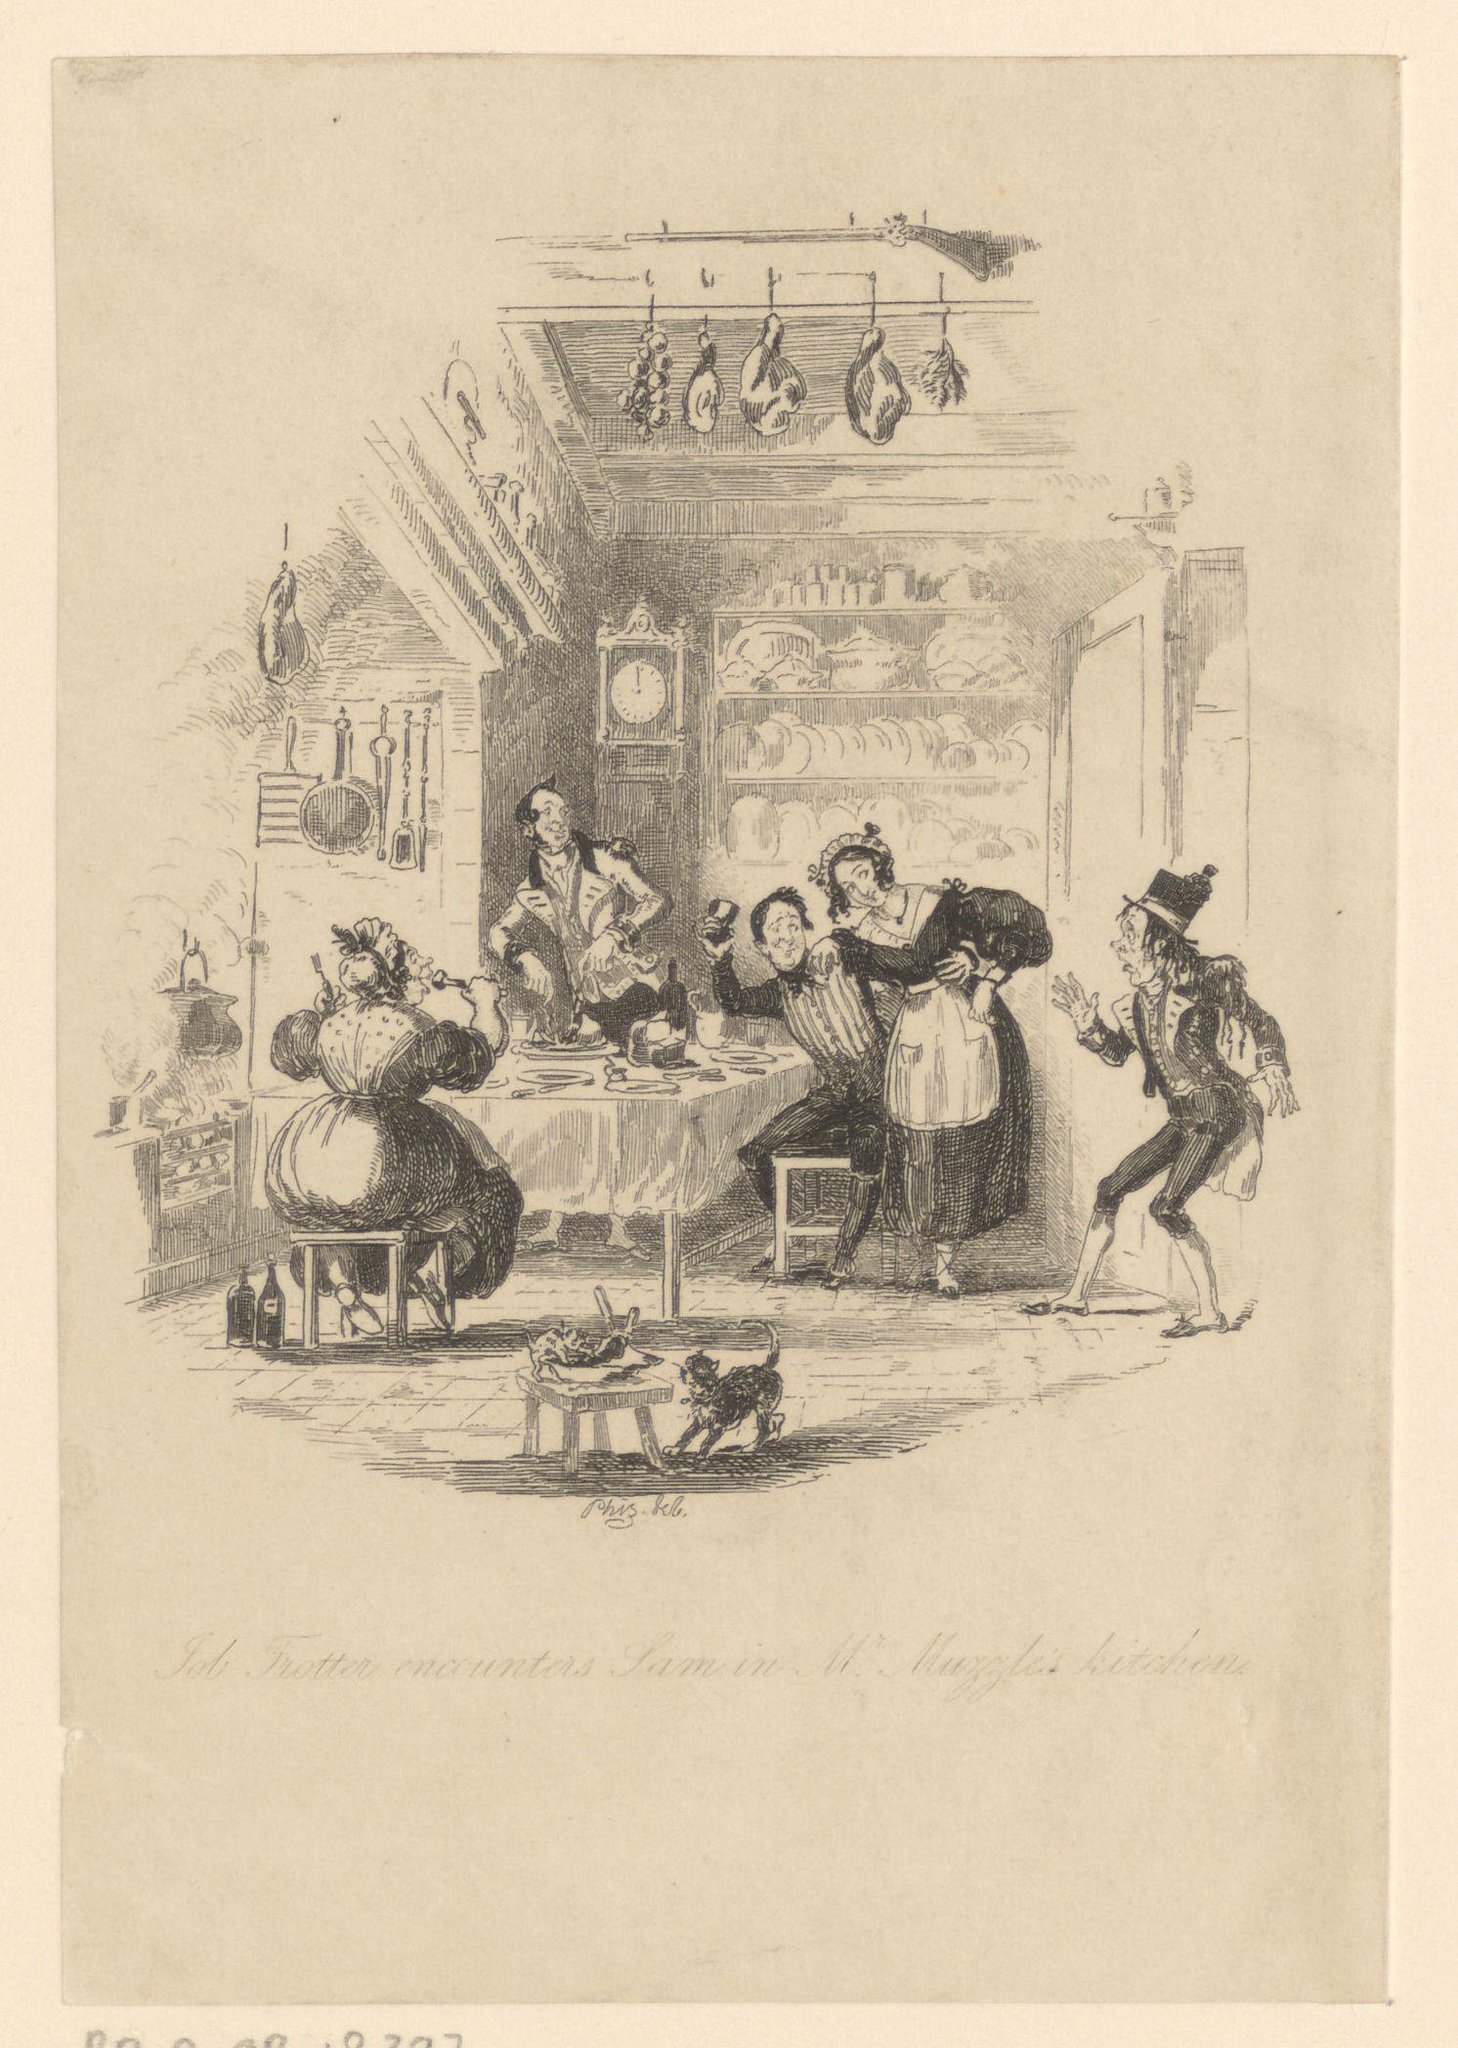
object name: print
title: Job Trotter encounters Sam in Mr. Muzzle's kitchen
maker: hablot knight browne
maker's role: print maker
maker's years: 1815-1882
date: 1812-1836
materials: paper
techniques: etching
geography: london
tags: alarm, fright; 'spavento', 'terrore' (ripa), kitchen-interior, drinking, eating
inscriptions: collector's mark: Lugt 2228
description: Prent uit: Dickens, Charles. The Pickwick Papers. Londen: Chapman and Hall, 1836-1837. Het boek werd tussen 1836 en 1837 eerst in delen uitgegeven. Deze prent werd in december 1836 uitgegeven.